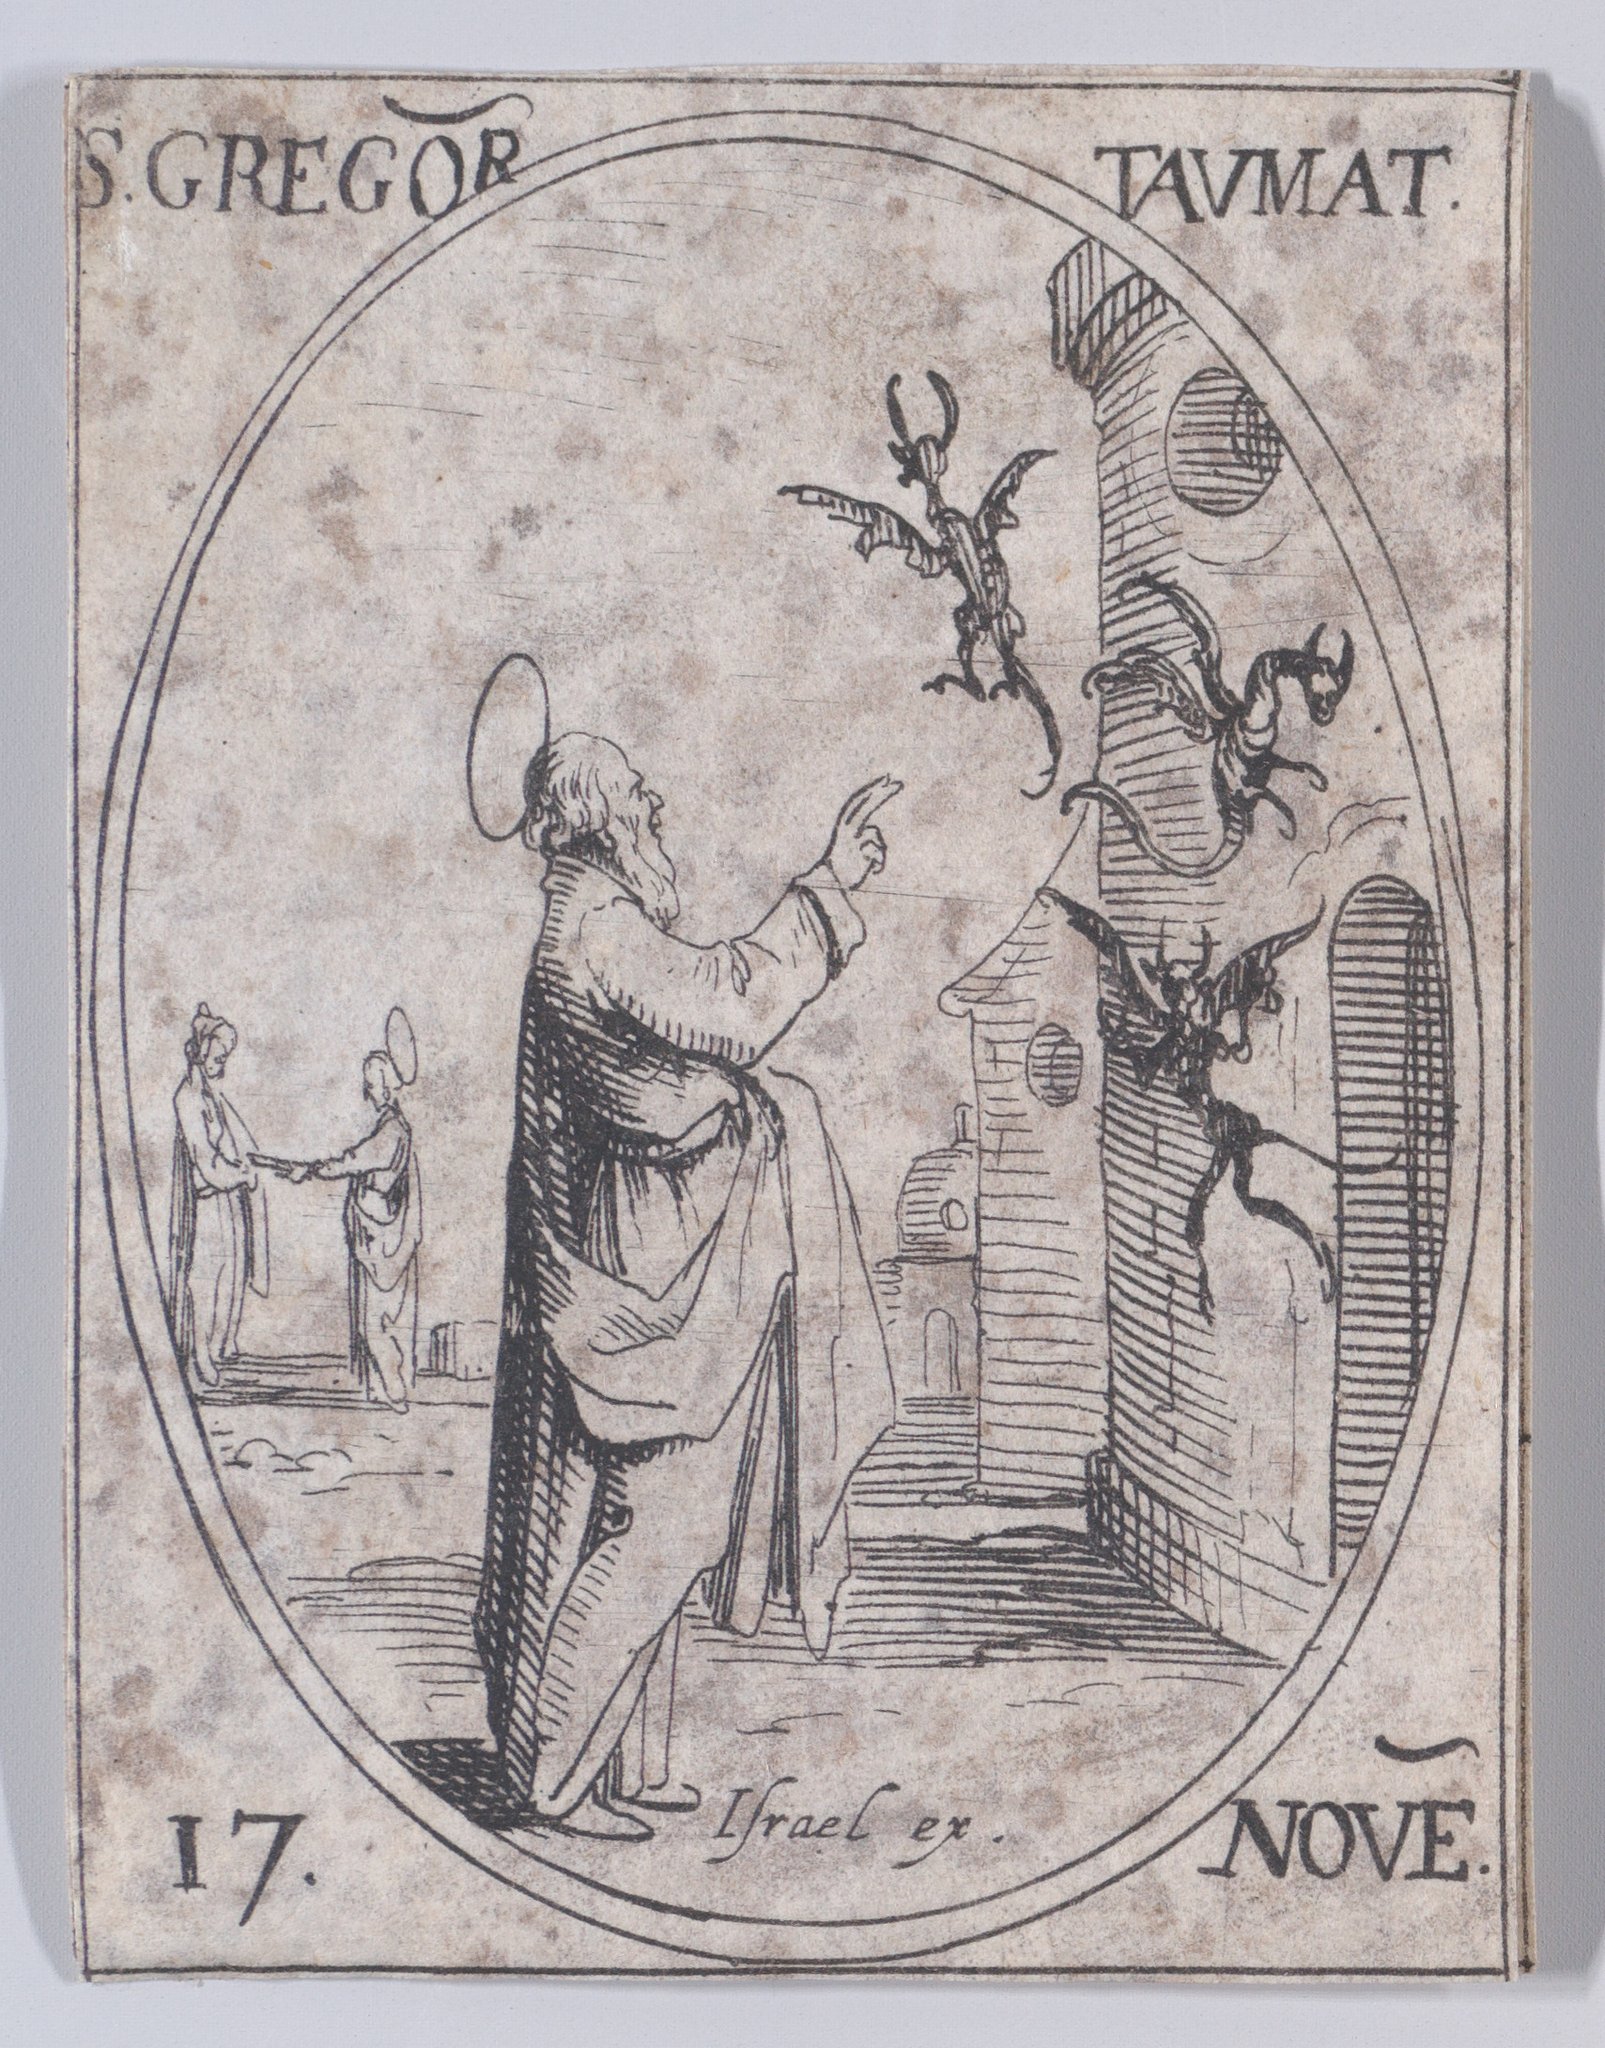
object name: print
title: S. Grégoire, taumaturge (St. Gregory, Thaumaturge), November 17th, from "Les Images De Tous Les Saincts et Saintes de L'Année" (Images of All of the Saints and Religious Events of the Year)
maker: jacques callot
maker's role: artist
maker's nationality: french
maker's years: 1592-1635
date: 1636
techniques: etching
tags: men,saints